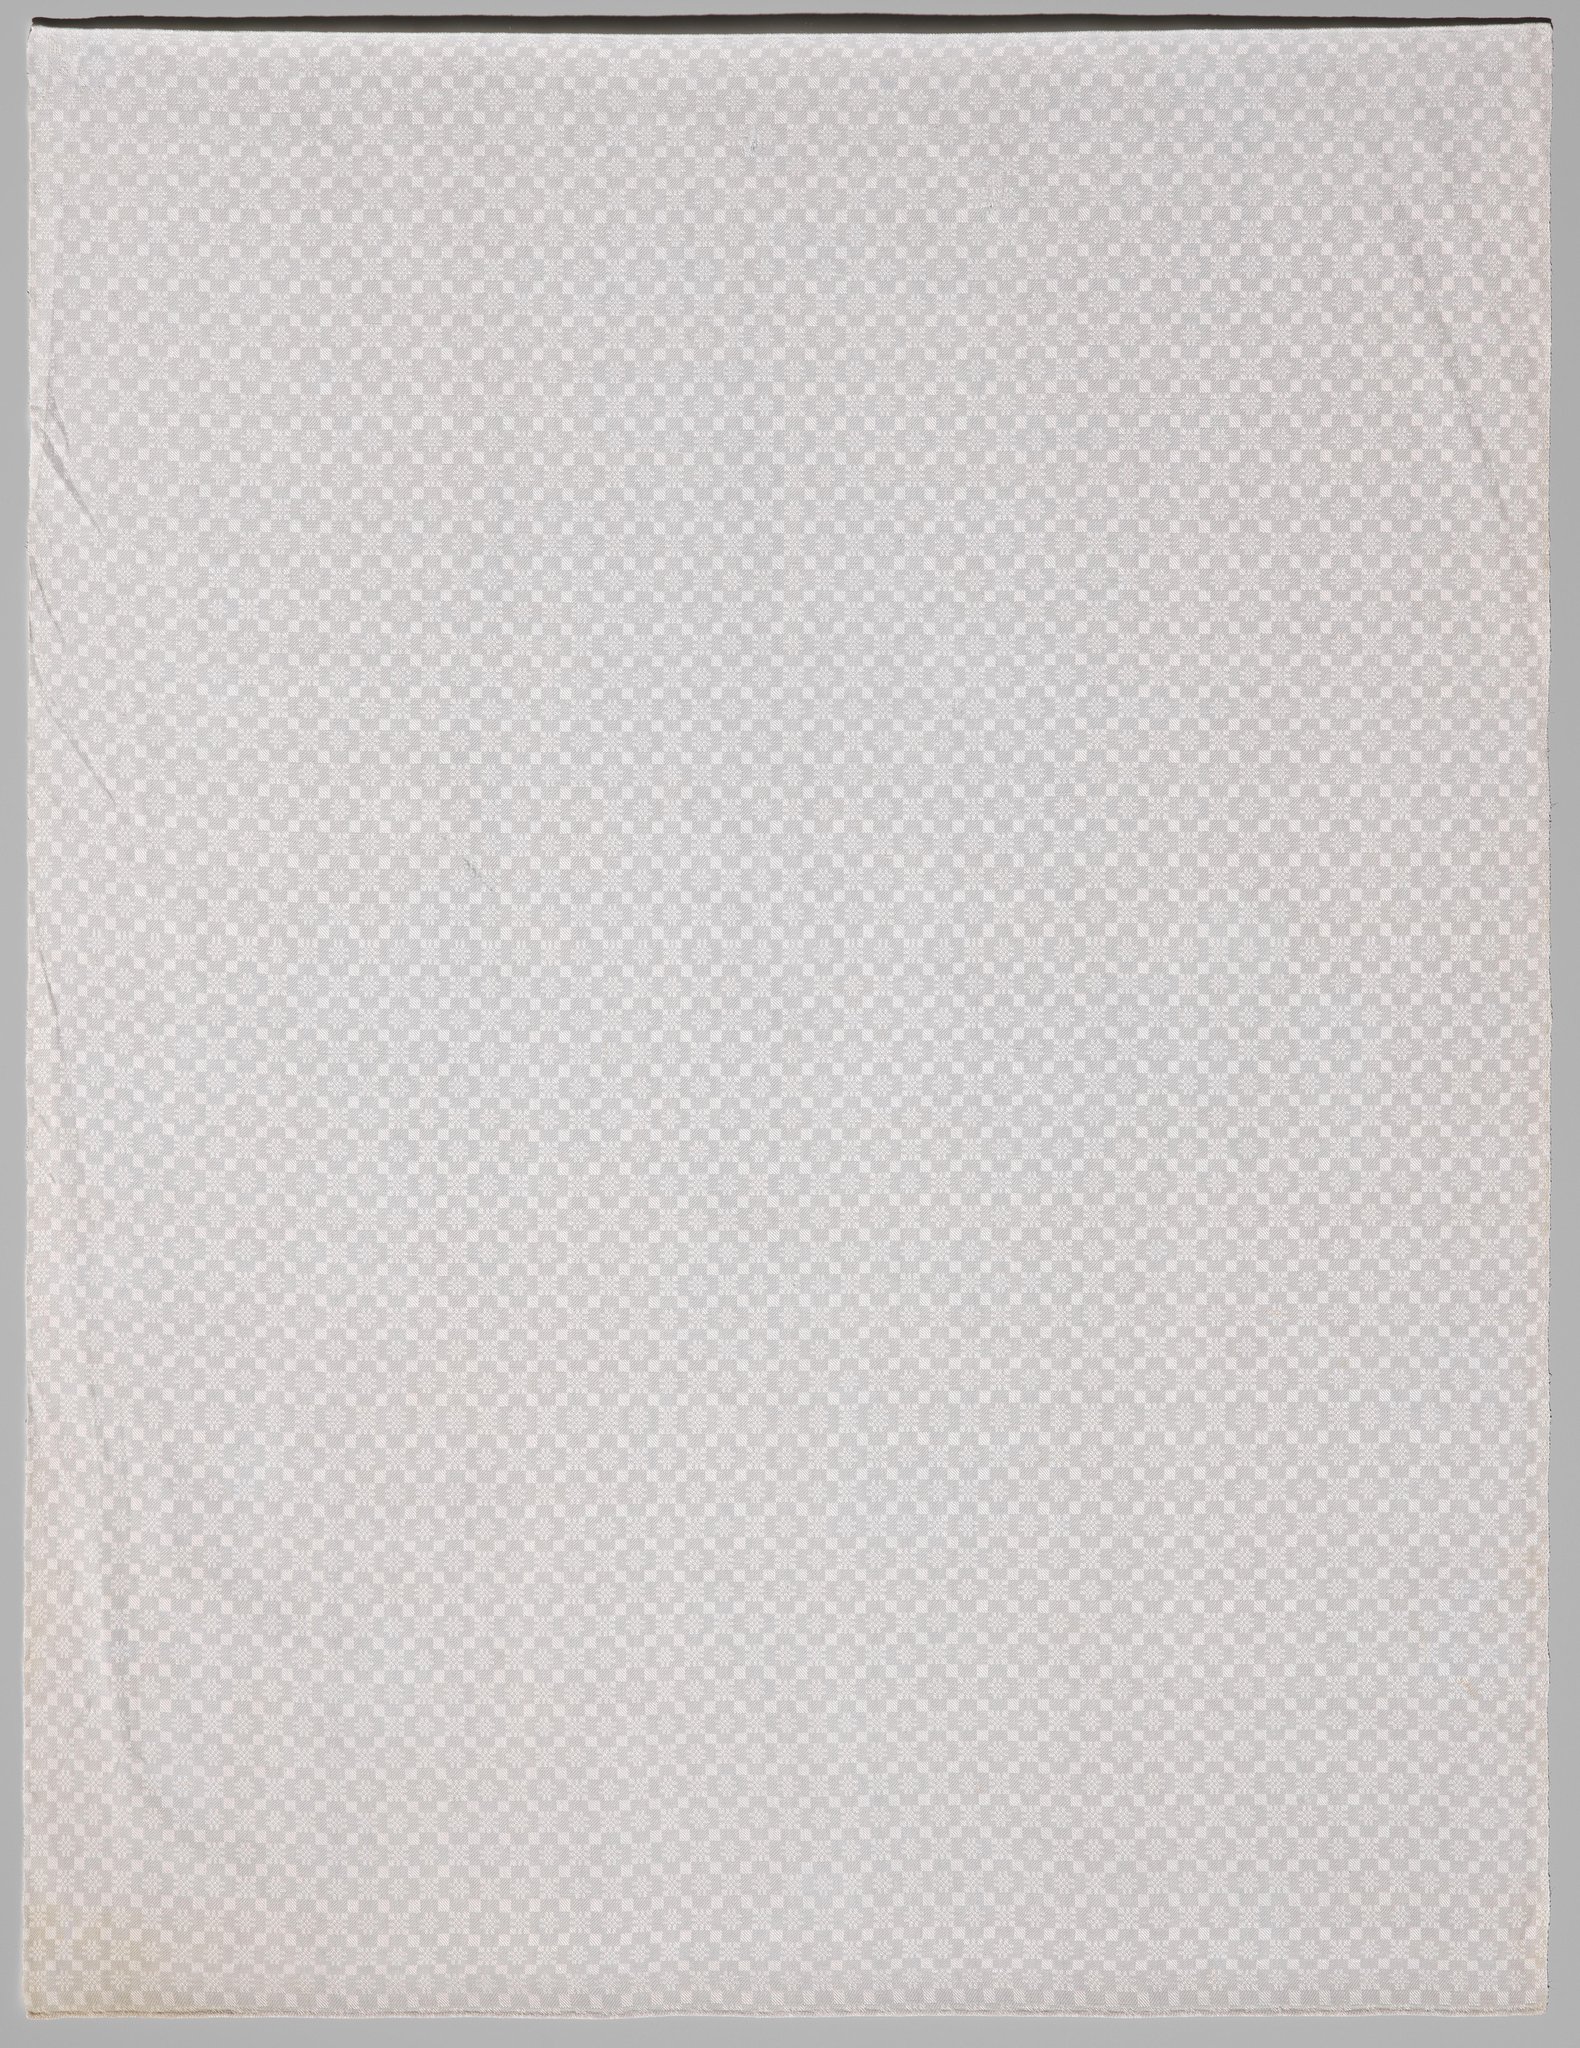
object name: napkin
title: Servet van linnendamast met pellenpatroon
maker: Anonymous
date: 1756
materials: linen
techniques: damask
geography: northern netherlands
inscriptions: : ‘WG 130 1756’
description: Wit linnen servet met een pellenpatroon in keperbinding, merk WG 130 1756.